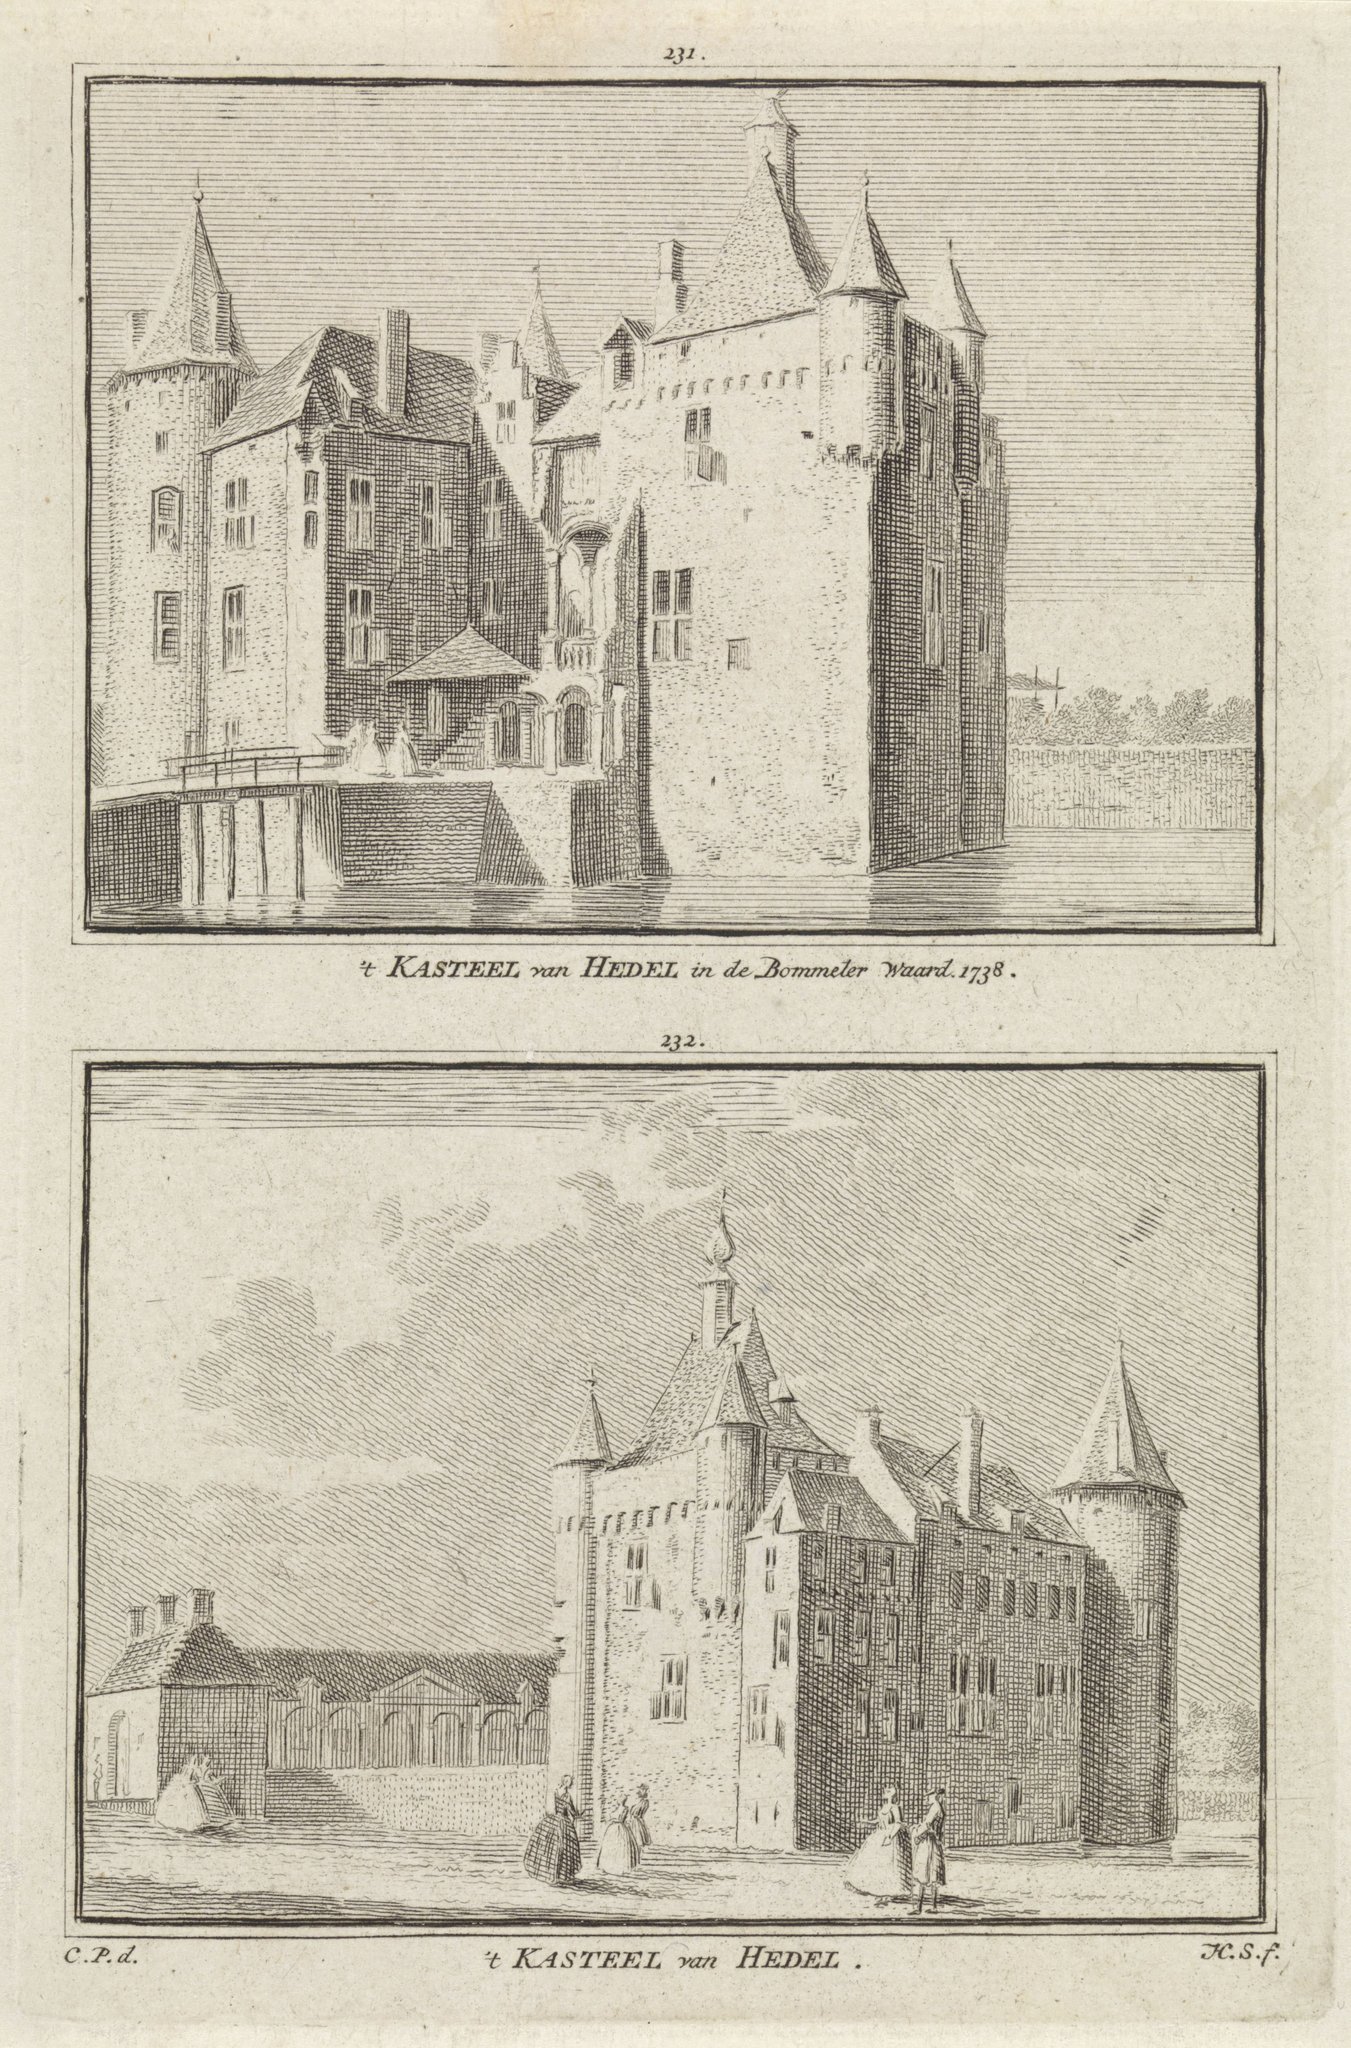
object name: print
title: 't Kasteel van Hedel in de Bommeler Waard 1738/ 't Kasteel van Hedel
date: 1750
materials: paper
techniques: etching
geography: haarlem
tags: castle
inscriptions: collector's mark: Lugt 2228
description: Prent gebruikt in: Het verheerlykt Nederland of kabinet van hedendaagsche gezigten van steden, dorpen, sloten ... en andere voornaame stad- en landgebouwen, in en omtrent alle de byzondere Vereenigde Nederlandsche Provinciën : gedurende de laatste jaaren door vermaarden kunsttekenaren na het leven getekent en ... in 't koper gebragt ... dienende tot opheldering der beschryvinge van den Tegenwoordigen Staat der Vereenigde Nederlanden. Deel III, 1750. Amsterdam: Isaac Tirion, 1745-1774.